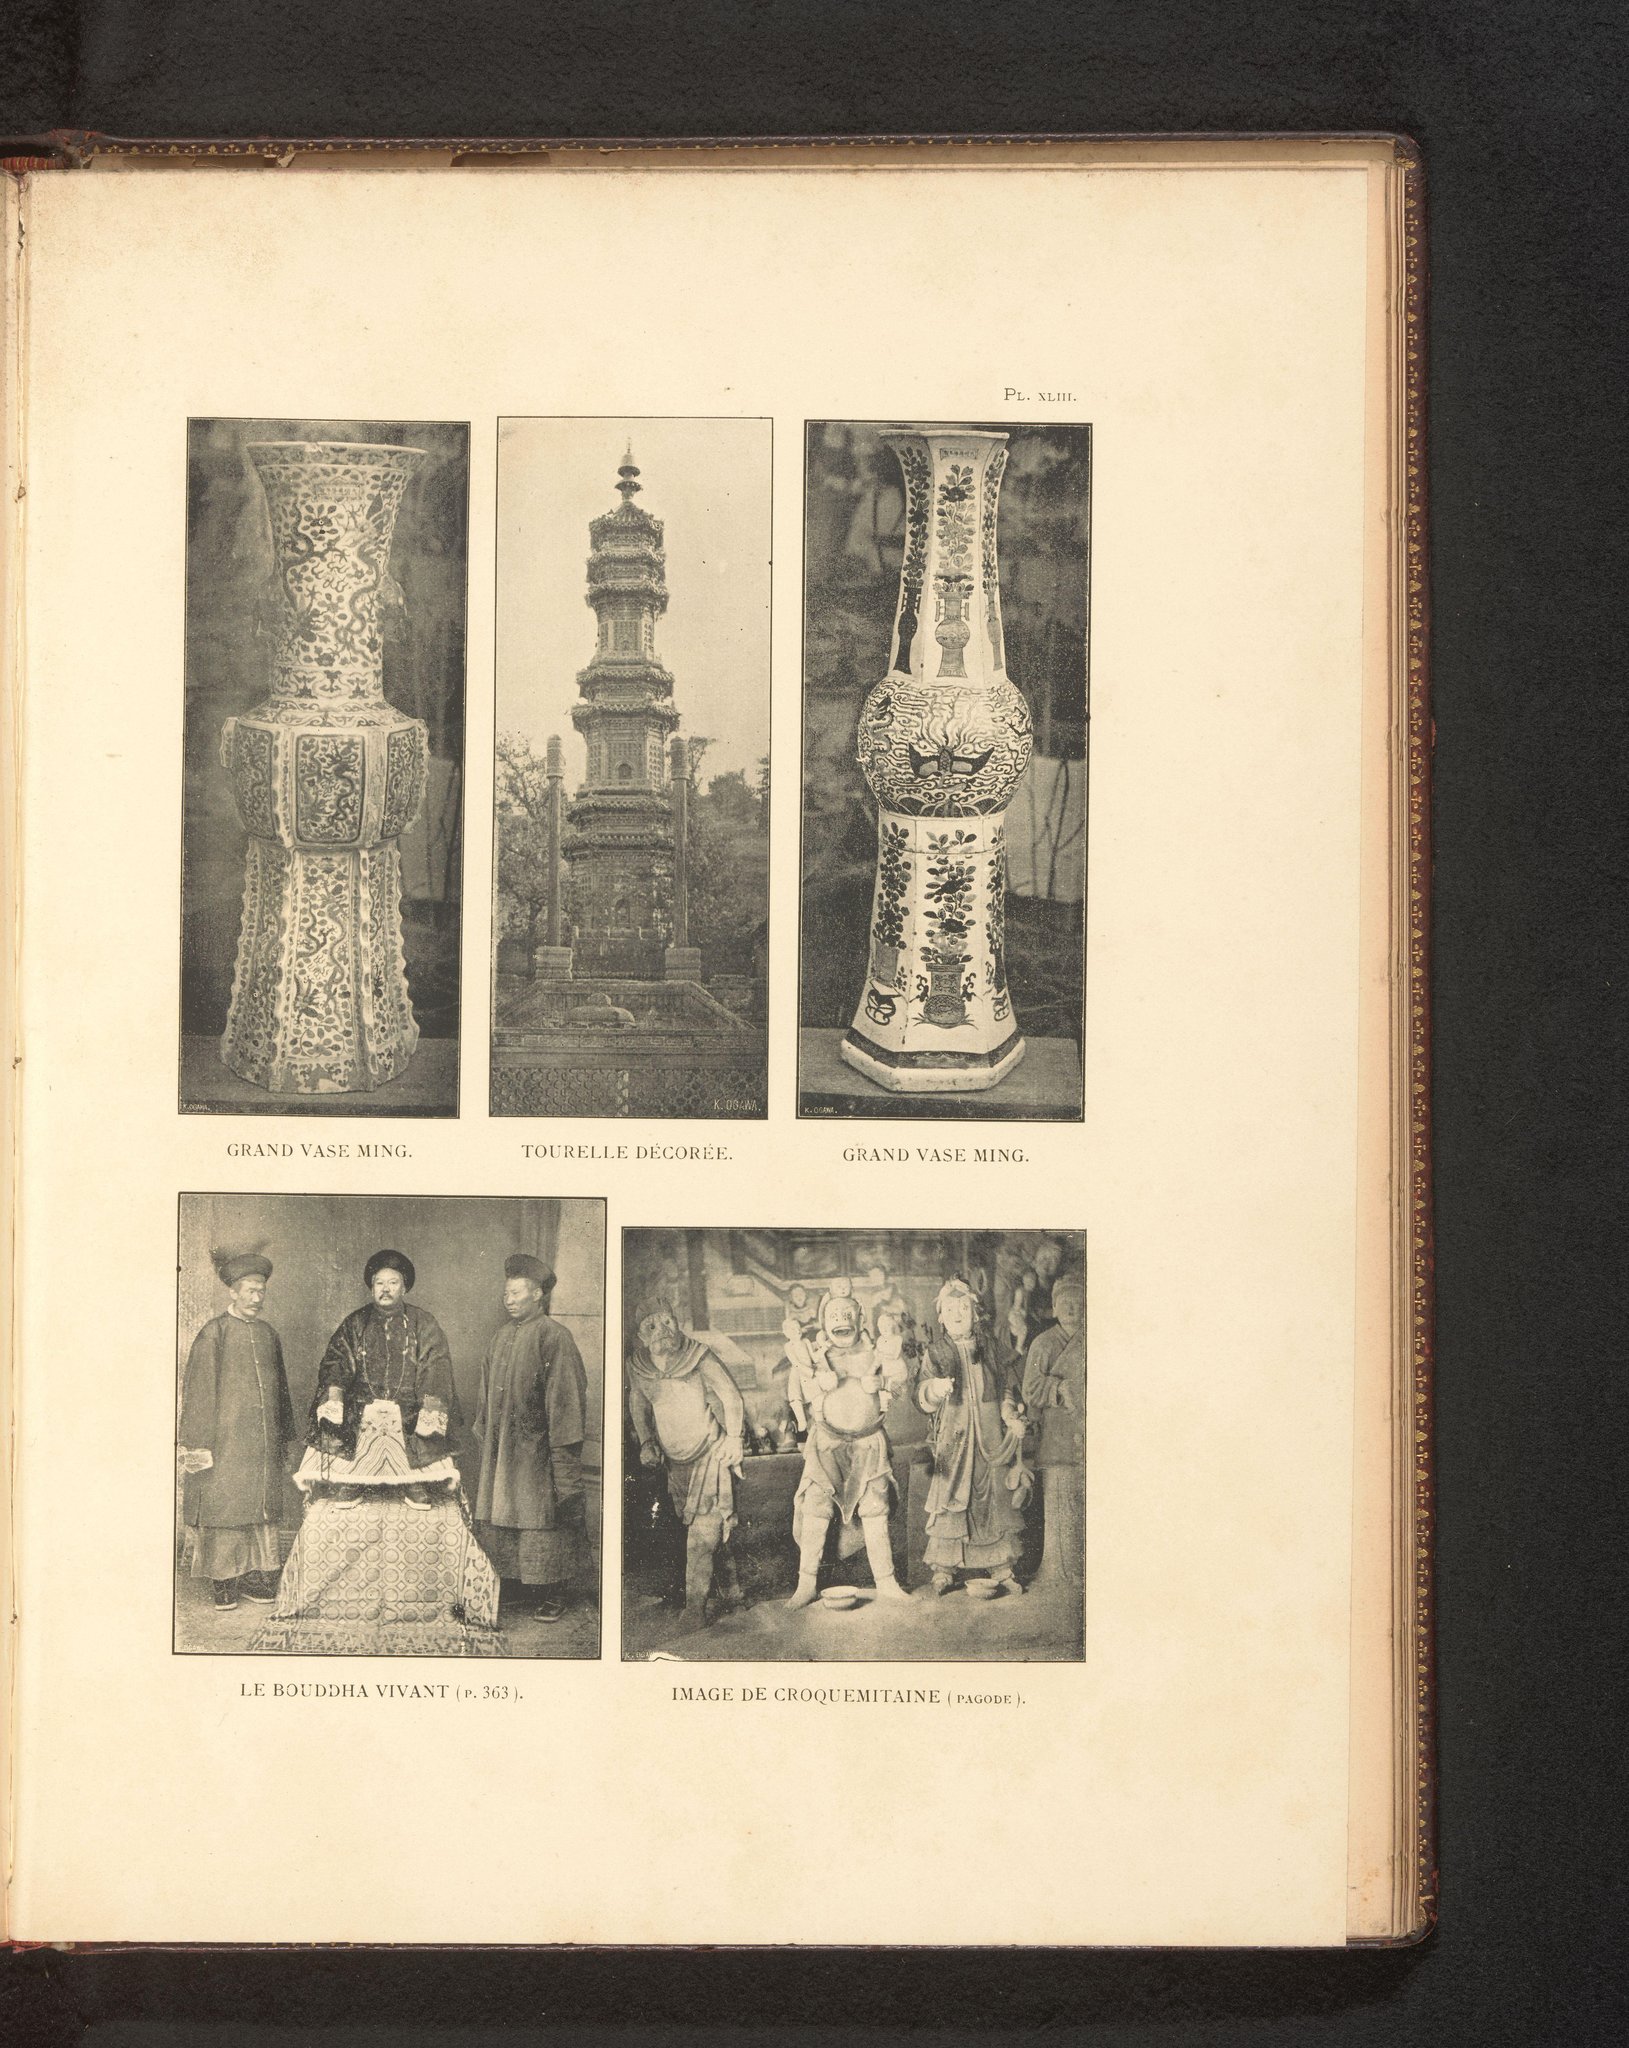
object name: page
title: Ming-vaas, Gezicht op een toren, Ming-vaas, Drie onbekende mannen en Onbekende personen in kostuum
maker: Anonymous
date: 1892-1897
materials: paper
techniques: autotype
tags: stage costume, historical persons, container of ceramics: jar, jug, pot, vase, china